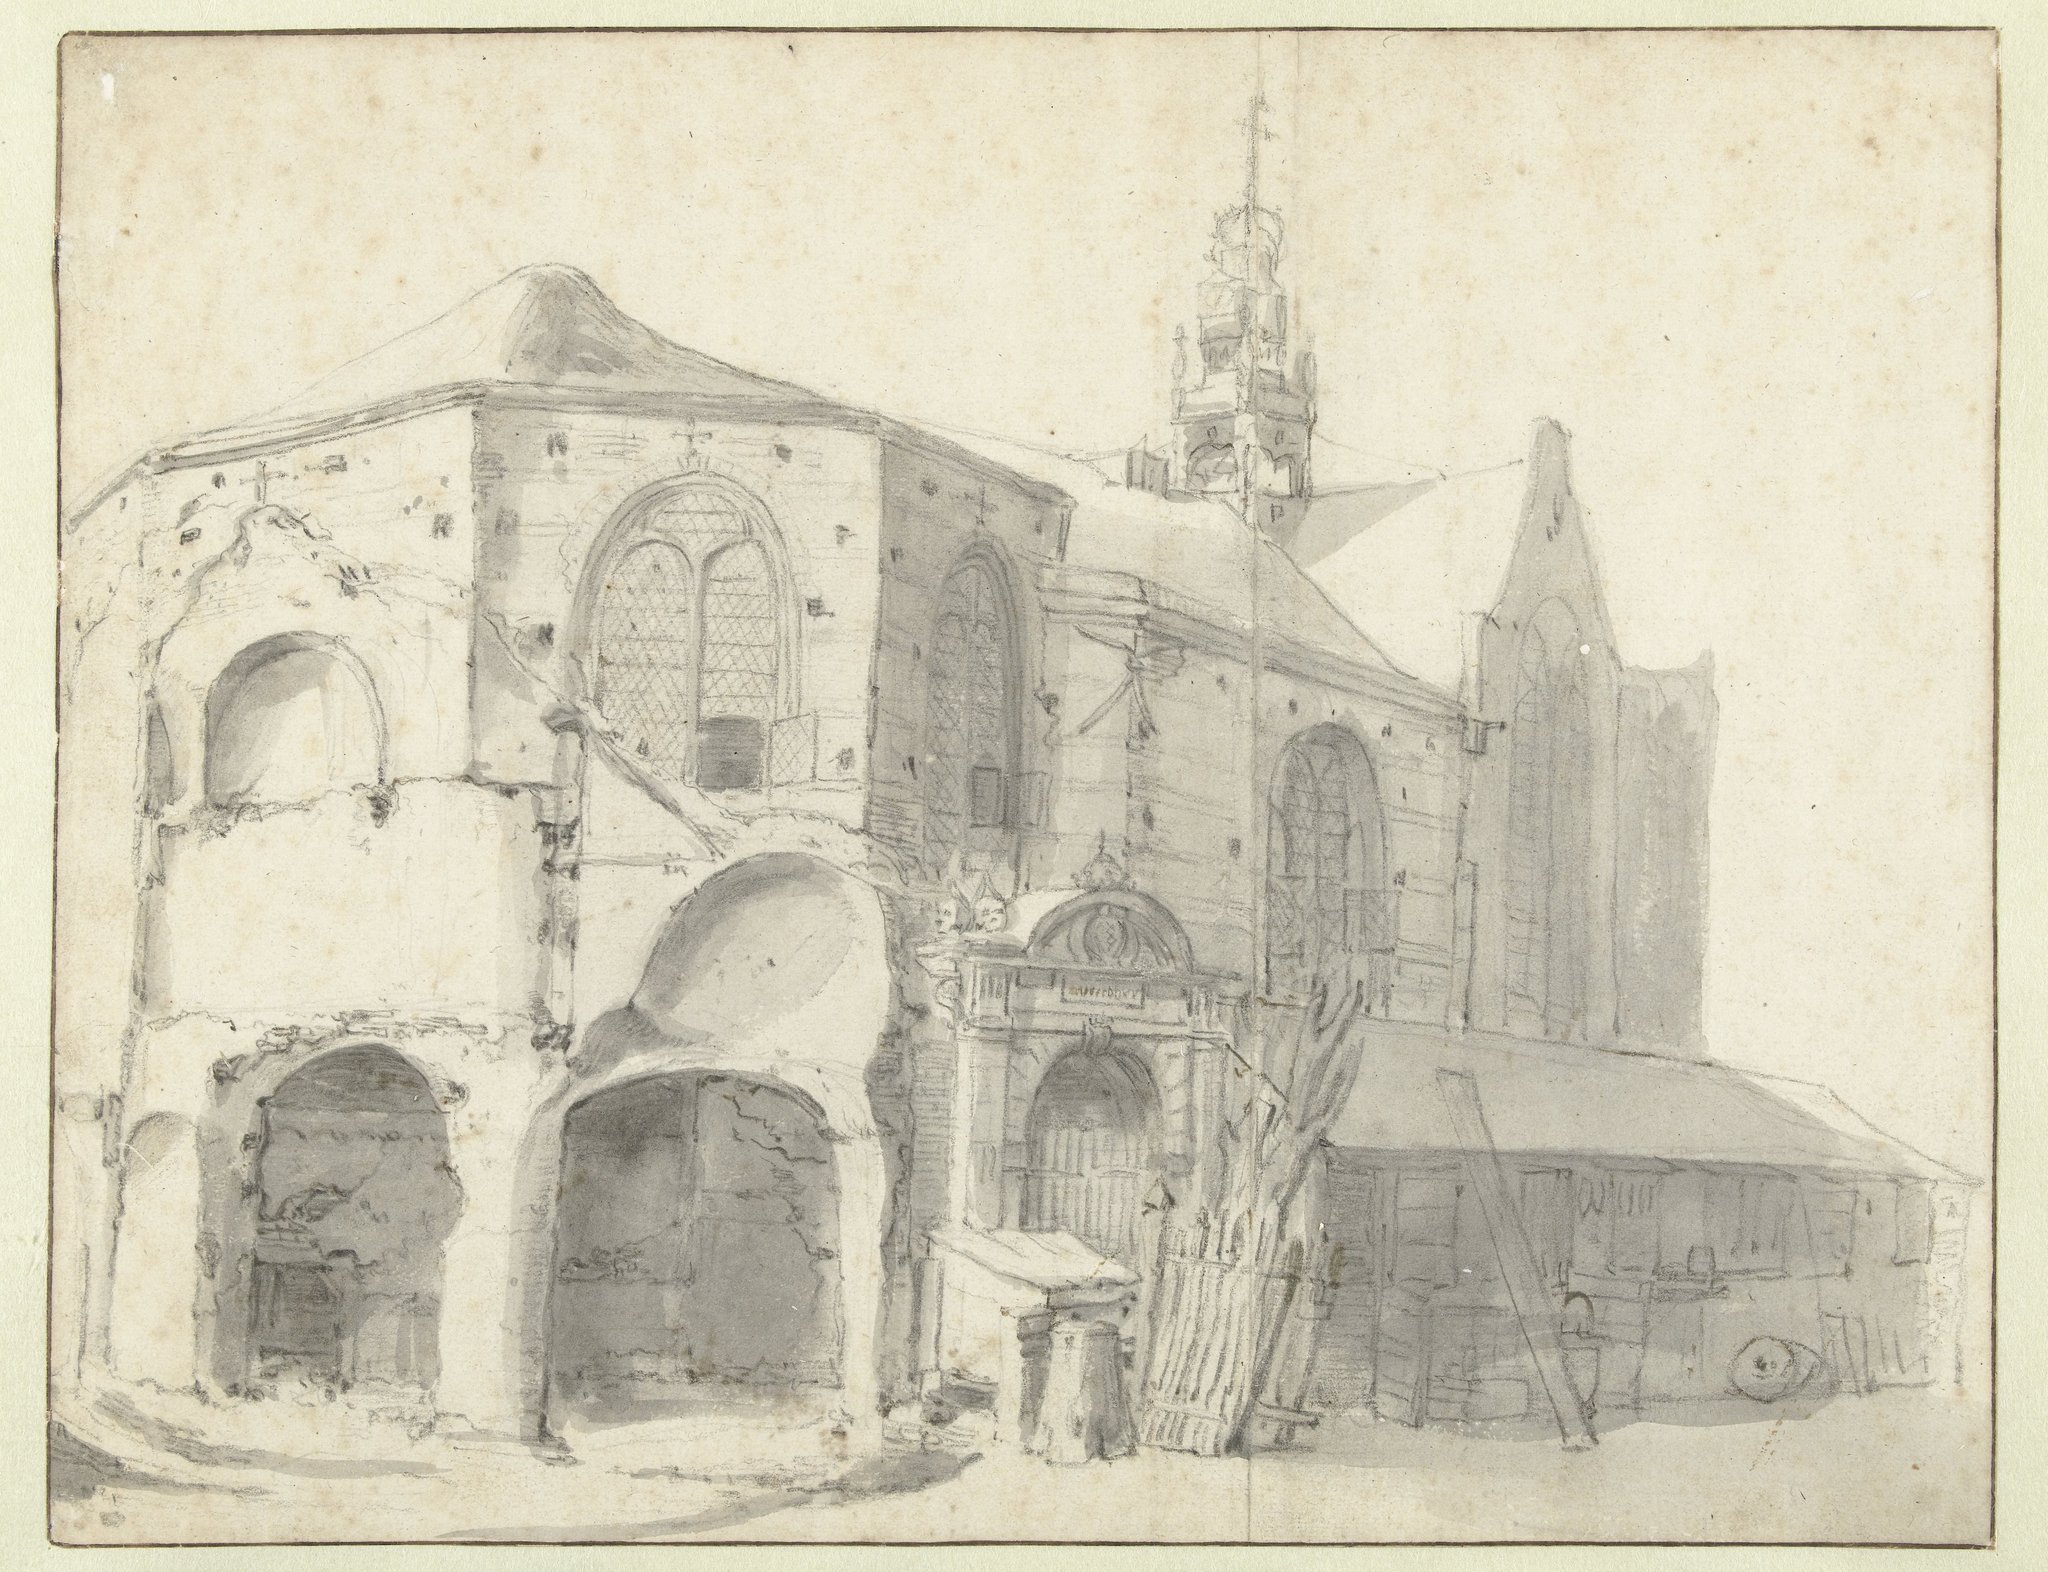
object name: drawing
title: View of the Jeruzalemkapel and the Sint Olofskapel, Amsterdam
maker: roelant roghman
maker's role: draughtsman, painter, print maker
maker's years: 1627-1692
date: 1644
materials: chalk, paper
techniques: brush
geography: amsterdam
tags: church (exterior), amsterdam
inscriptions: date: ‘1644’